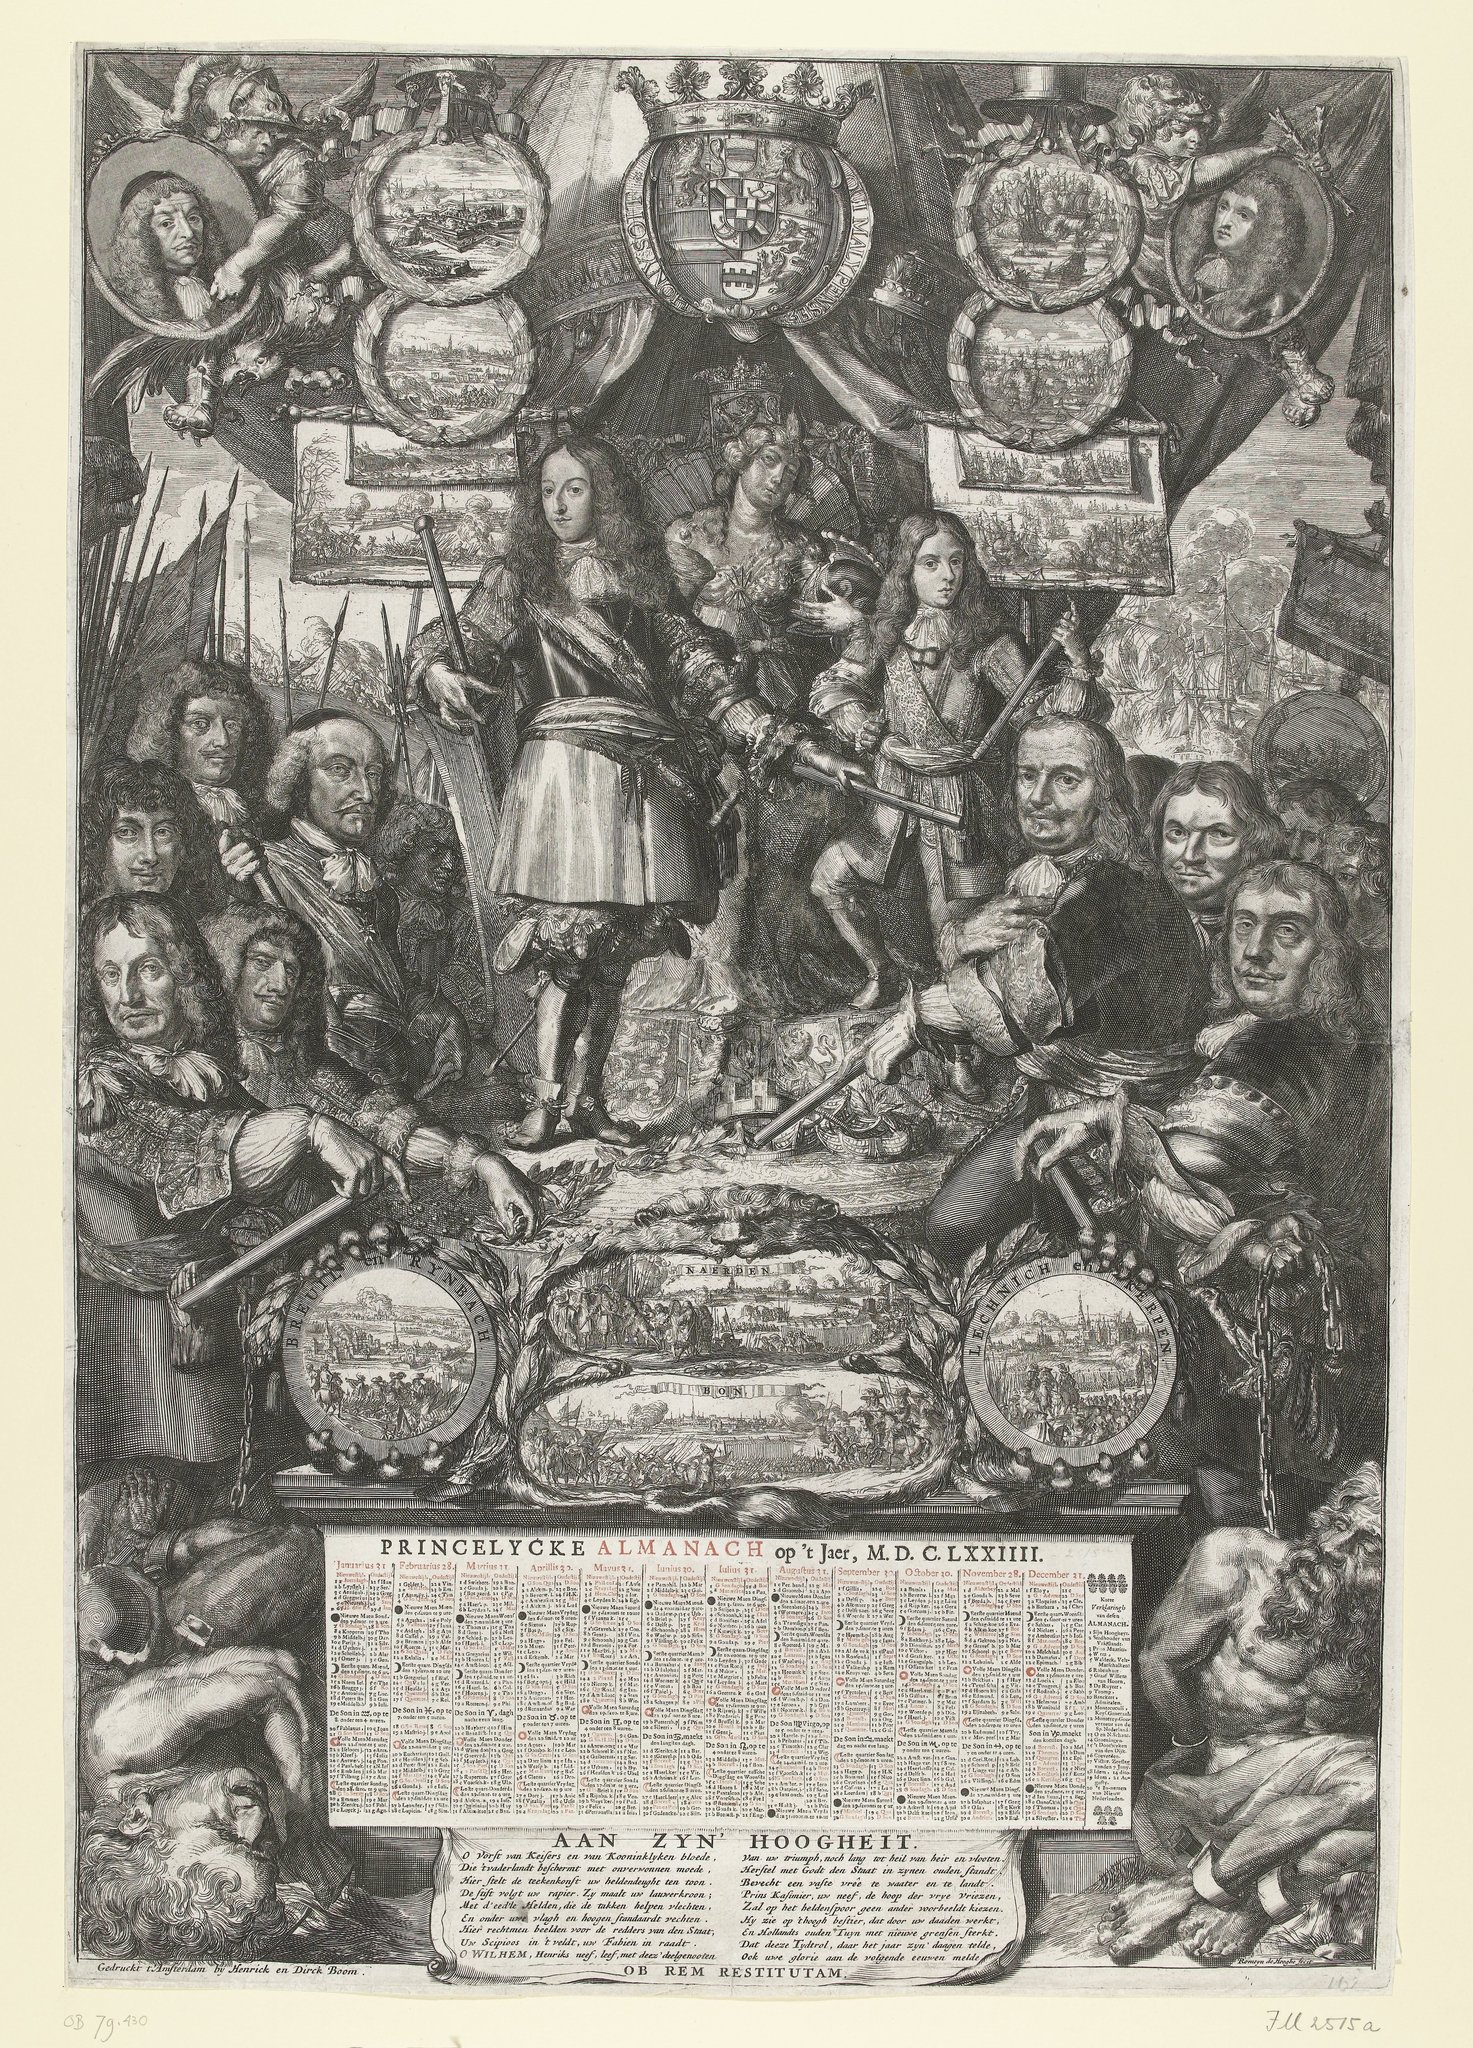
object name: propagandaprent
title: Allegorie op de overwinningen van Willem III in 1673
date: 1673-1674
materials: paper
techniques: engraving, etching, letterpress printing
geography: amsterdam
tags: flushing, michiel adriaenszoon de ruyter, rotterdam, cornelis tromp, earl, johan maurits graaf van nassau-siegen, the hague, william iii (prince of orange and king of england, scotland, and ireland), juan domingo méndez de haro y fernández de córdoba, middelburg, hendrik casimir ii graaf van nassau-dietz, commander-in-chief, general, marshal, prince, military glory, commander-in-chief, admiral, rampjaar (disaster year)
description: Allegorie op de overwinningen van Willem III in 1673. De jonge prins met commandostaf staande naast de jonge Hendrik Casimir. Hiervoor bevelhebbers die in 1673 overwinningen behaalden: Michiel Adriaenszoon de Ruyter, Cornelis Tromp, Adriaen Banckert, Johan Maurits, Paulus Wirtz, George Frederik van Waldeck, Rabenhaupt en graaf Willem van Hornes. Hieromheen medaillons en cartouches met overwinningen. Bovenaan links het portret van Montecuccoli en rechts Monterrey. Onderaan opgeplakt een almanak voor het jaar 1674 gedrukt in zwart en rood. Aan weerszijden van de almanak geketende gevangenen. In de plaat onder de almanak een vers in twee kolommen in het Nederlands gericht aan de vorst.